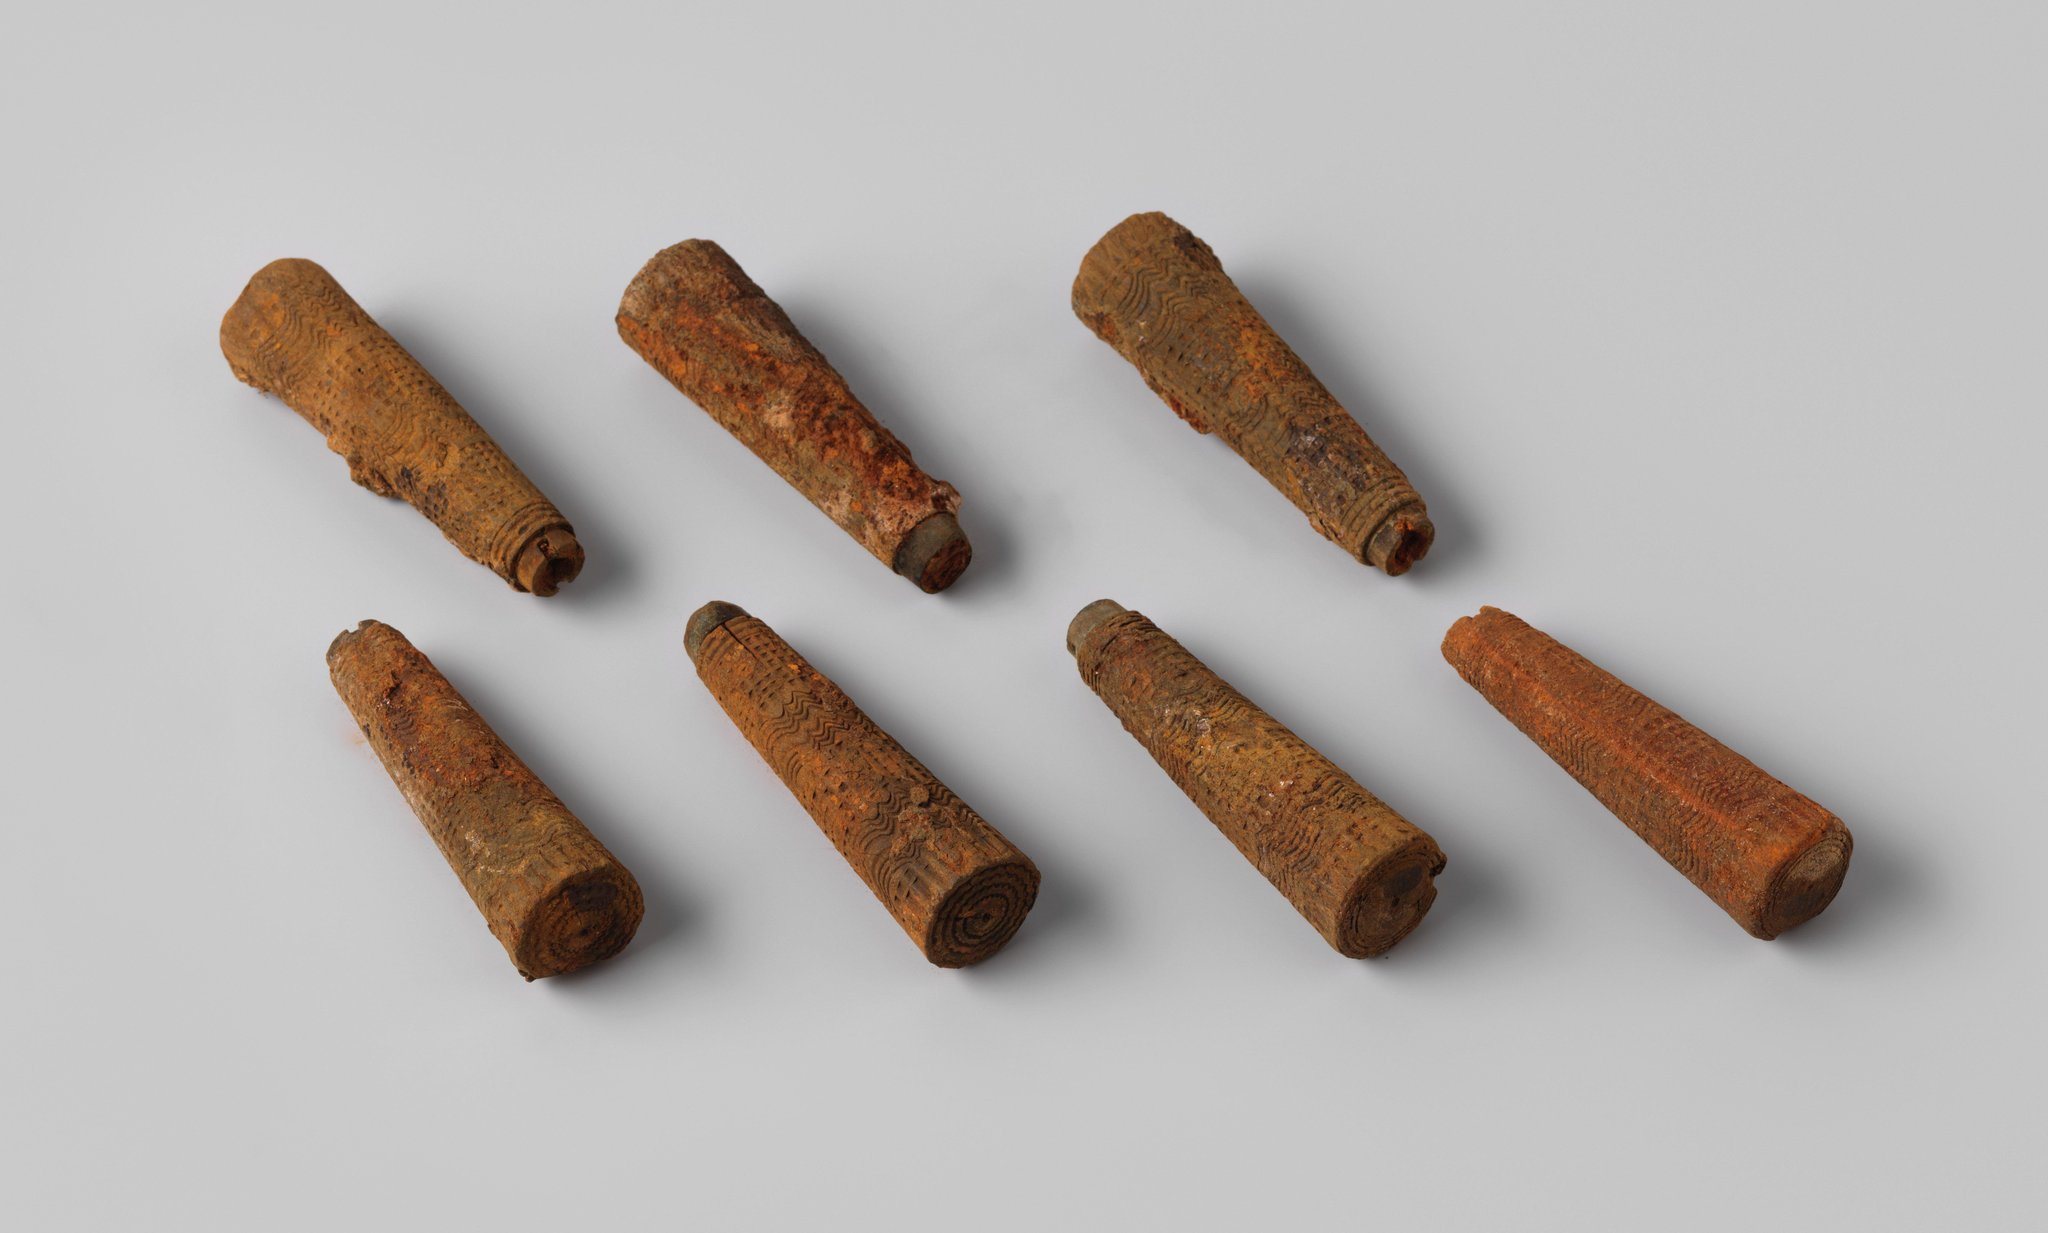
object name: knife handle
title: Messenheften uit het wrak van de Oost-Indiëvaarder Hollandia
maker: Anonymous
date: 1700-1743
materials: wood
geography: netherlands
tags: verenigde oostindische compagnie, hollandia (schip), annet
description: Knife, handle, cylindrical: tapering; id. 403H.